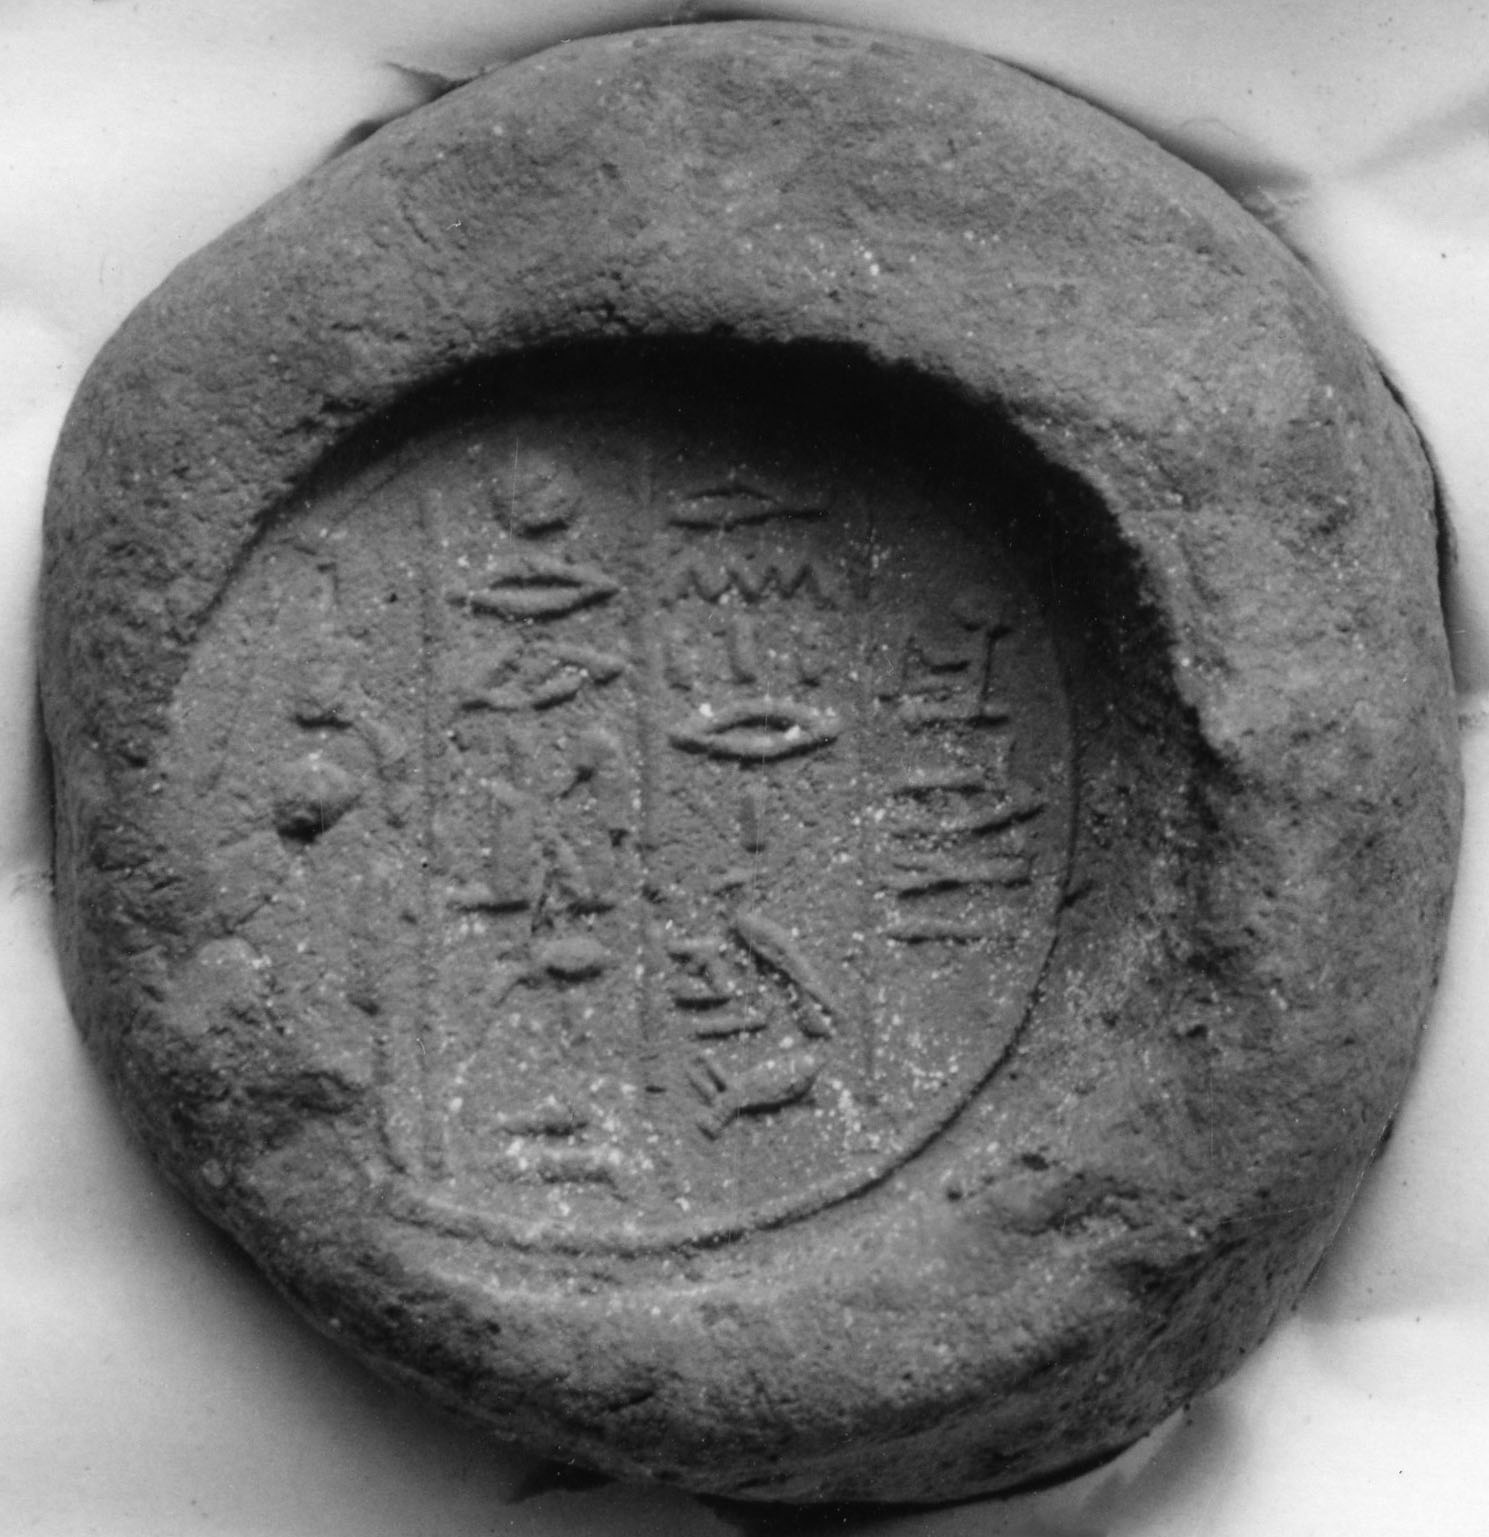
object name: cone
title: Funerary Cones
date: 1550-1295 BCE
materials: pottery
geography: egypt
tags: hieroglyphs